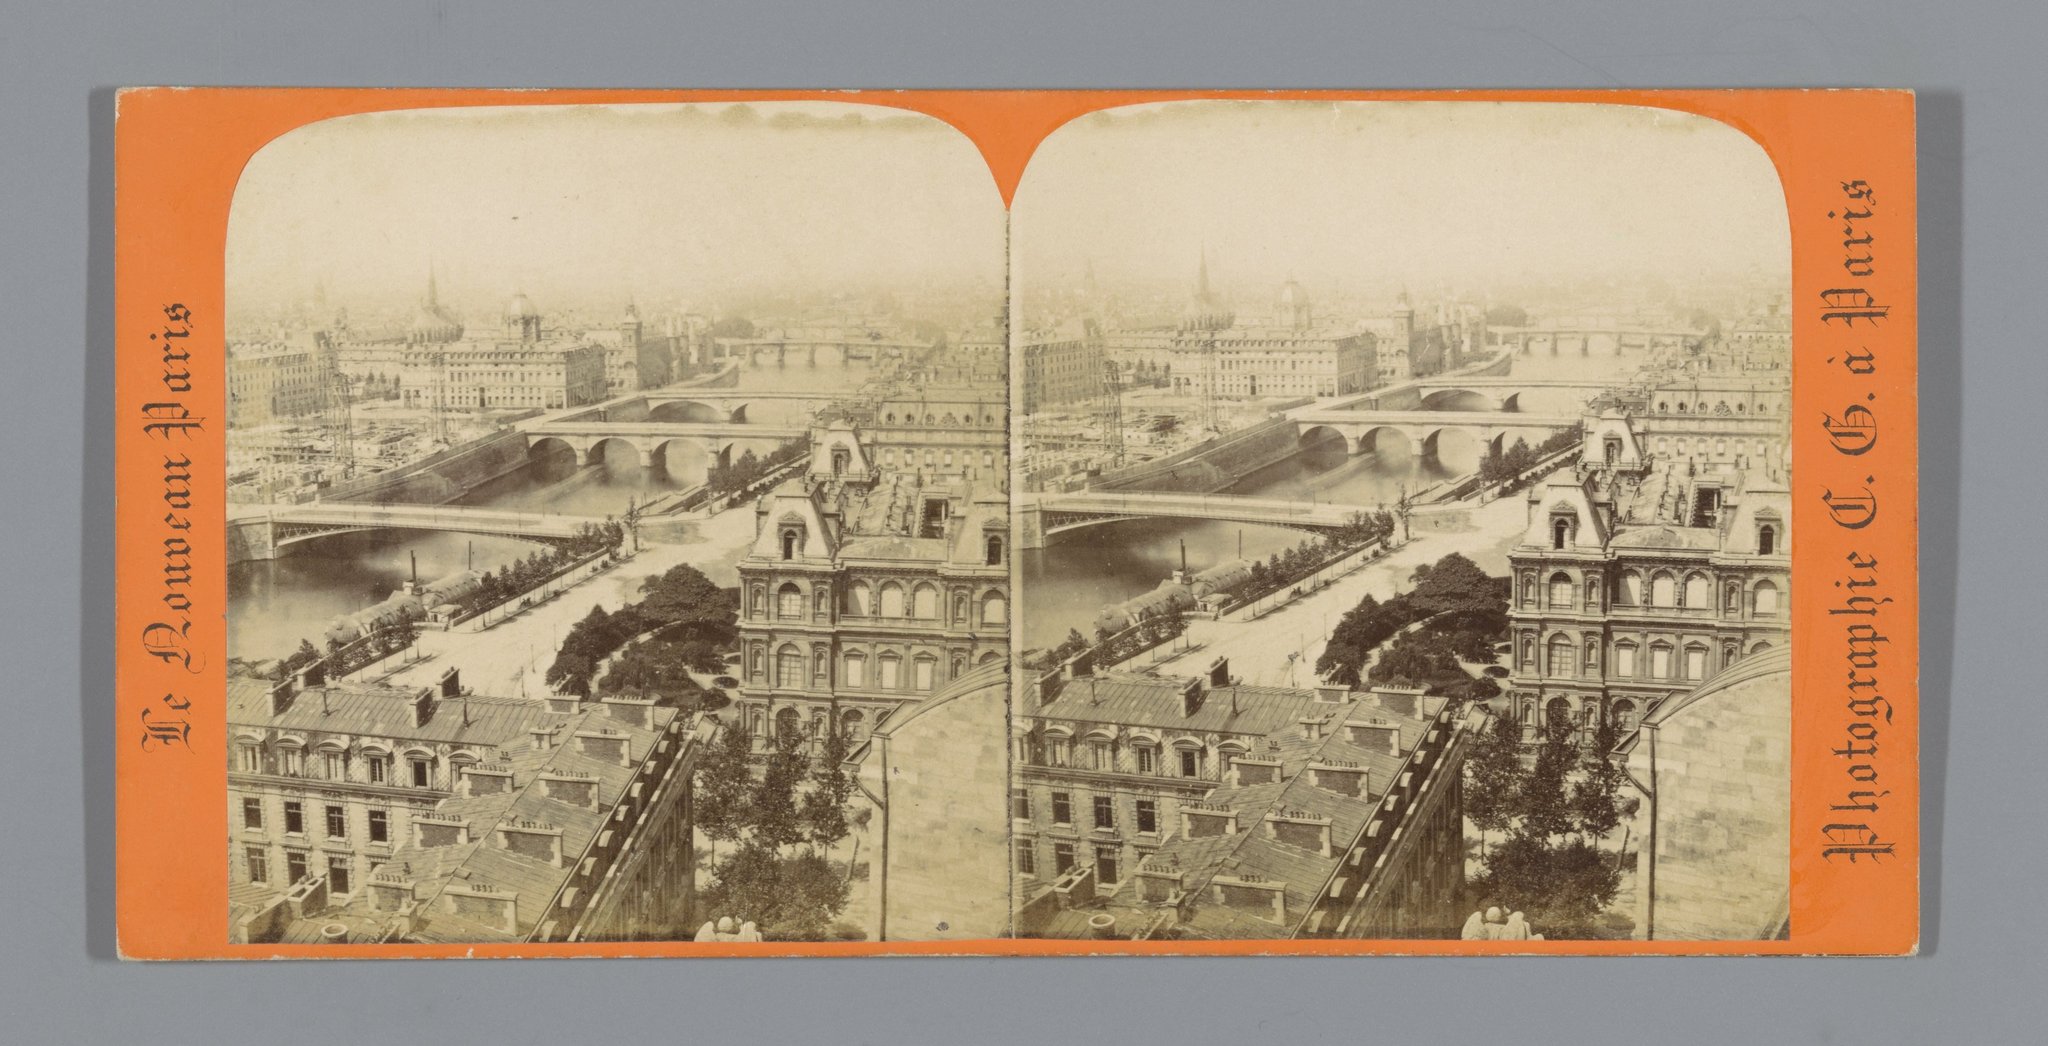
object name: stereograph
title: Gezicht op bruggen over de Seine te Parijs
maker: charles gérard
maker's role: fotograaf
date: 1850-1875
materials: cardboard, photographic support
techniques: albumen print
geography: paris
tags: city-view in general; 'veduta', river, bridge, paris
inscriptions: inscription: ‘Les 7 ponts’